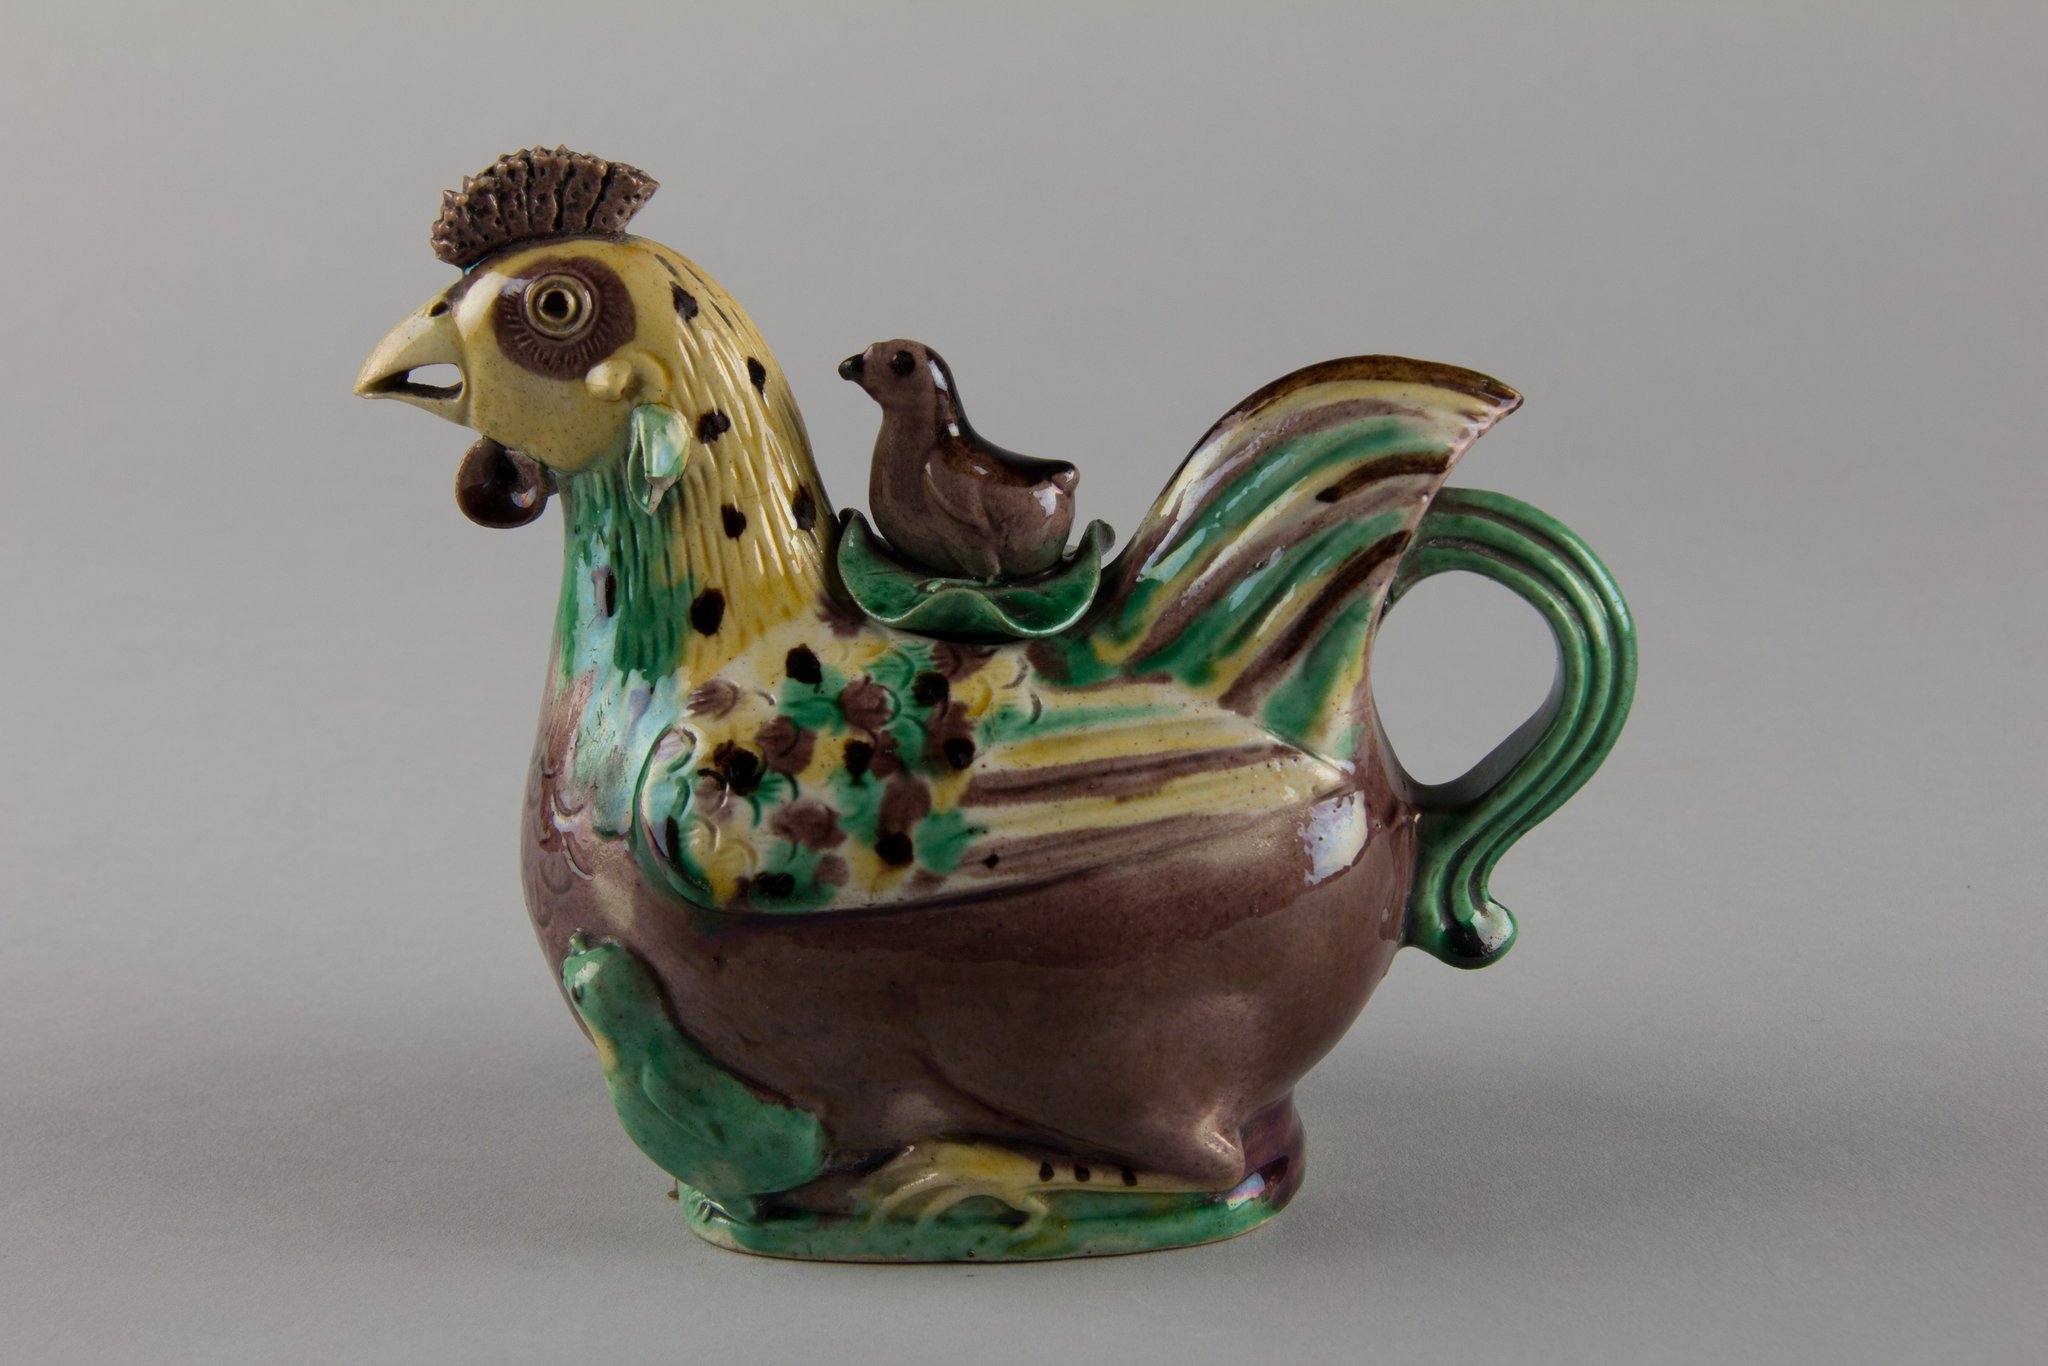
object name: ewer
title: Chicken-form ewer (one of a pair)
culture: chinese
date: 1667-1733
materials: biscuit, enamel, porcelain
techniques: painting, polychrome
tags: chickens